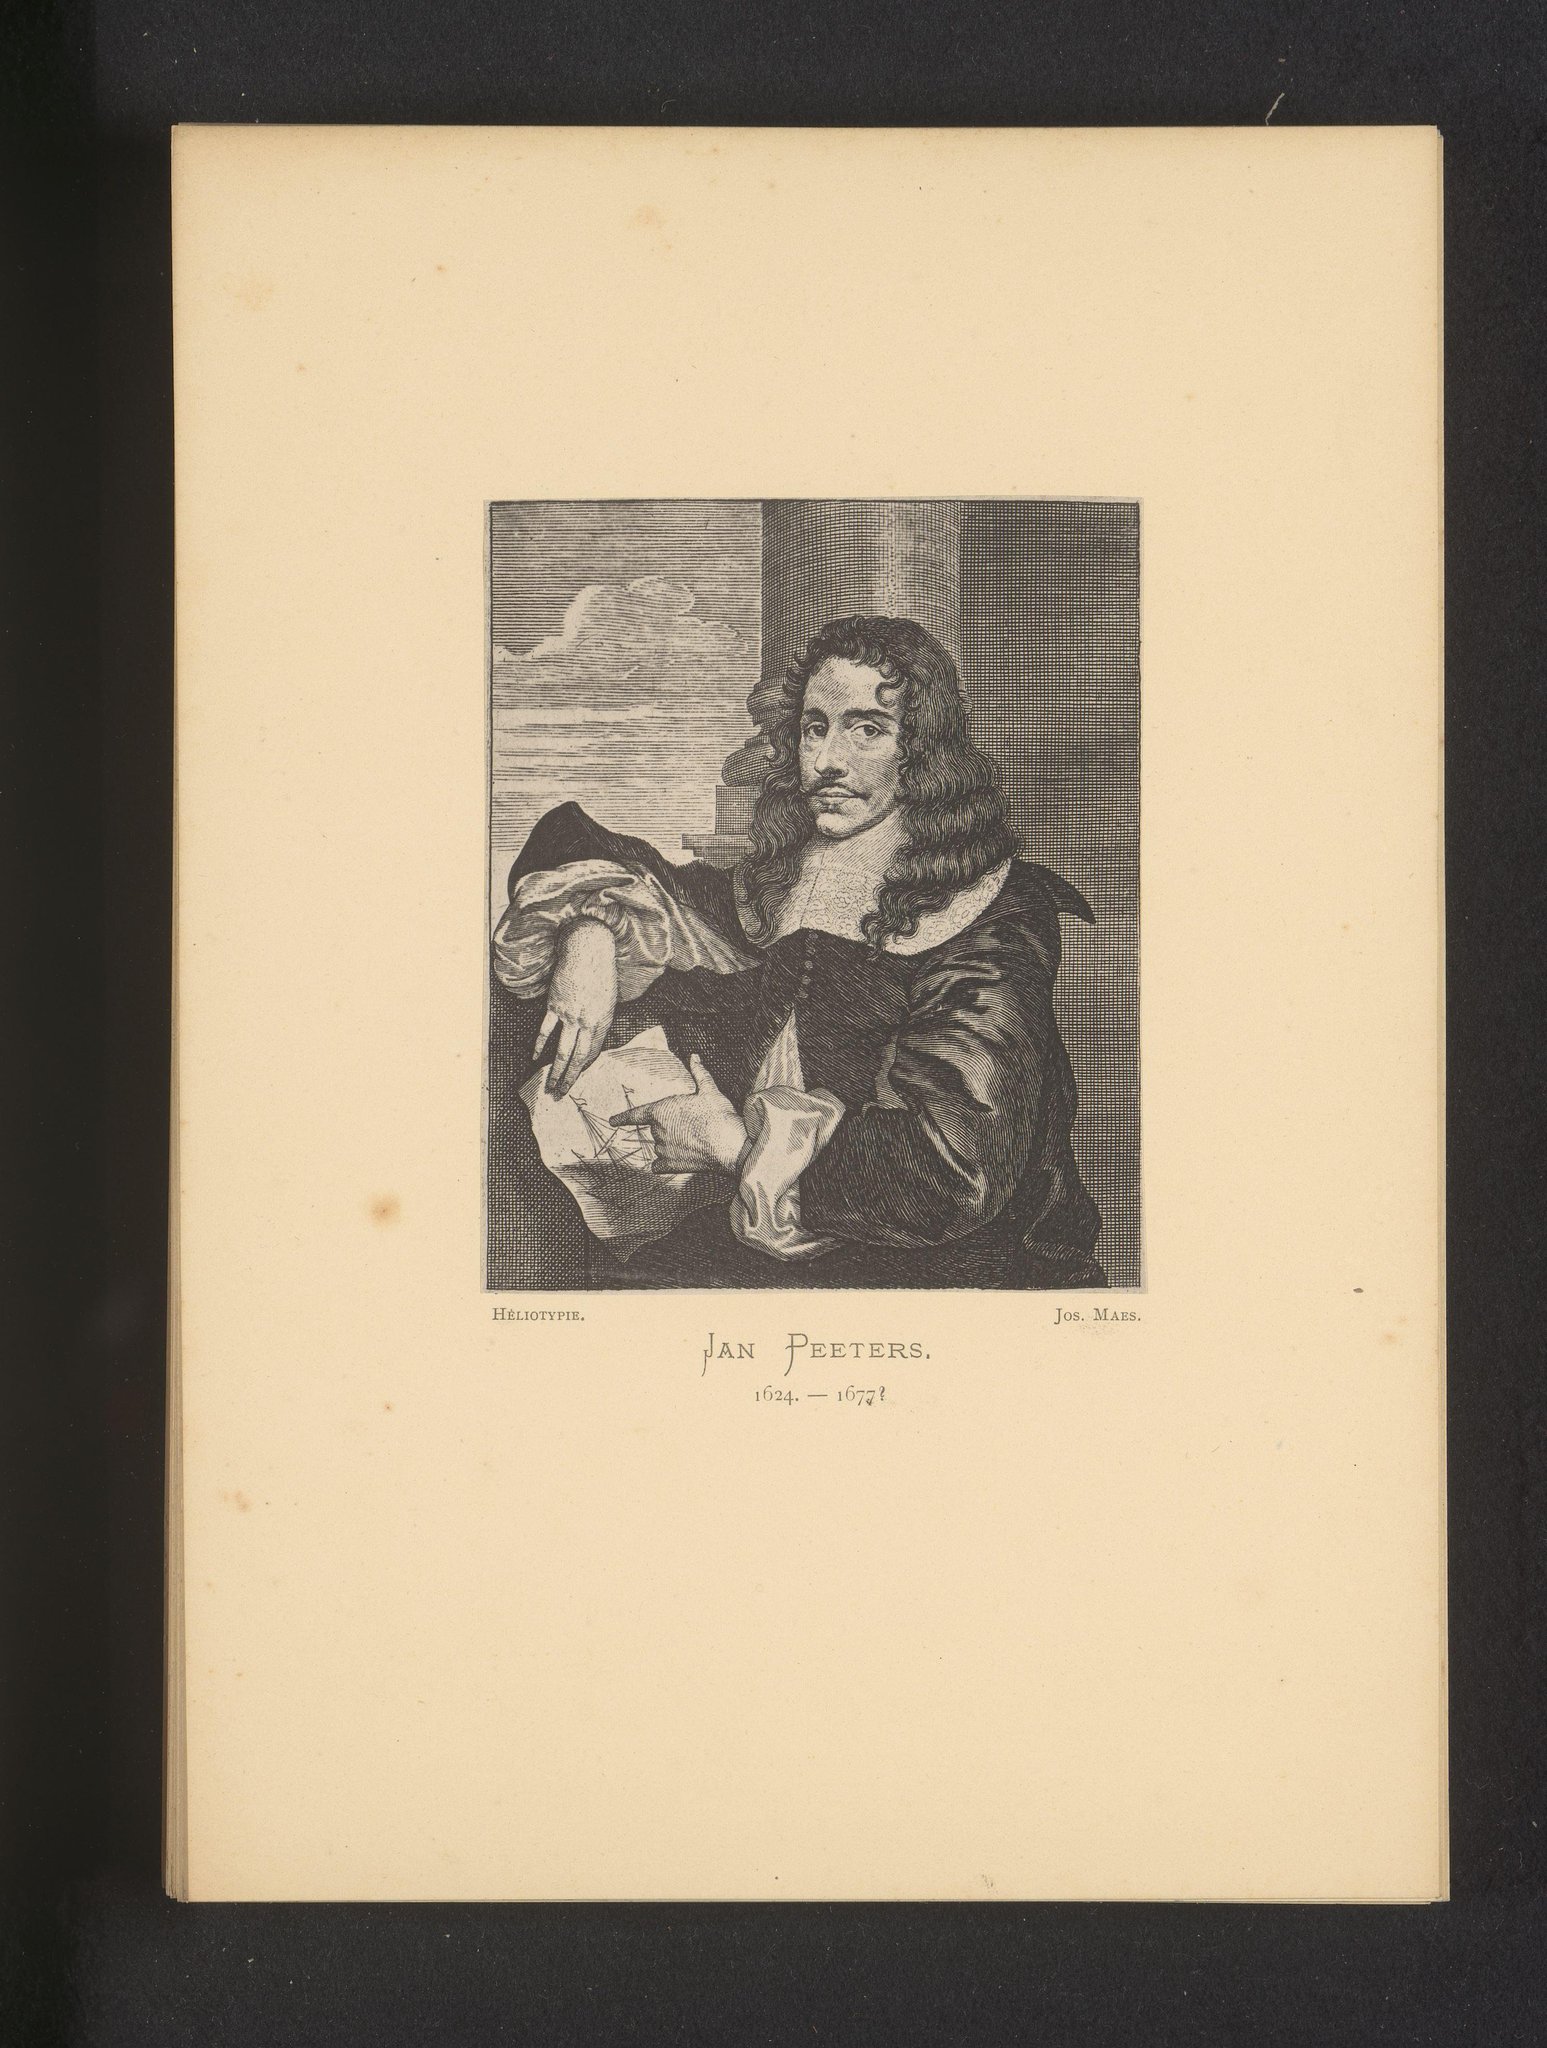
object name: reproduction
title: Reproductie van een gravure van een portret van Jan Peeters door Lucas Vorsterman (I)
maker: joseph maes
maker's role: fotograaf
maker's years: 1838-1908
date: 1872-1877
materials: cardboard, paper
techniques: photograph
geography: antwerp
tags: antwerp, draughtsman, jan peeters (i), historical persons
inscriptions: inscription: ‘1624. - 1677?’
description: Deze prent maakt deel uit van een omslag met 150 prenten en een katern met een lijst van afbeeldingen.